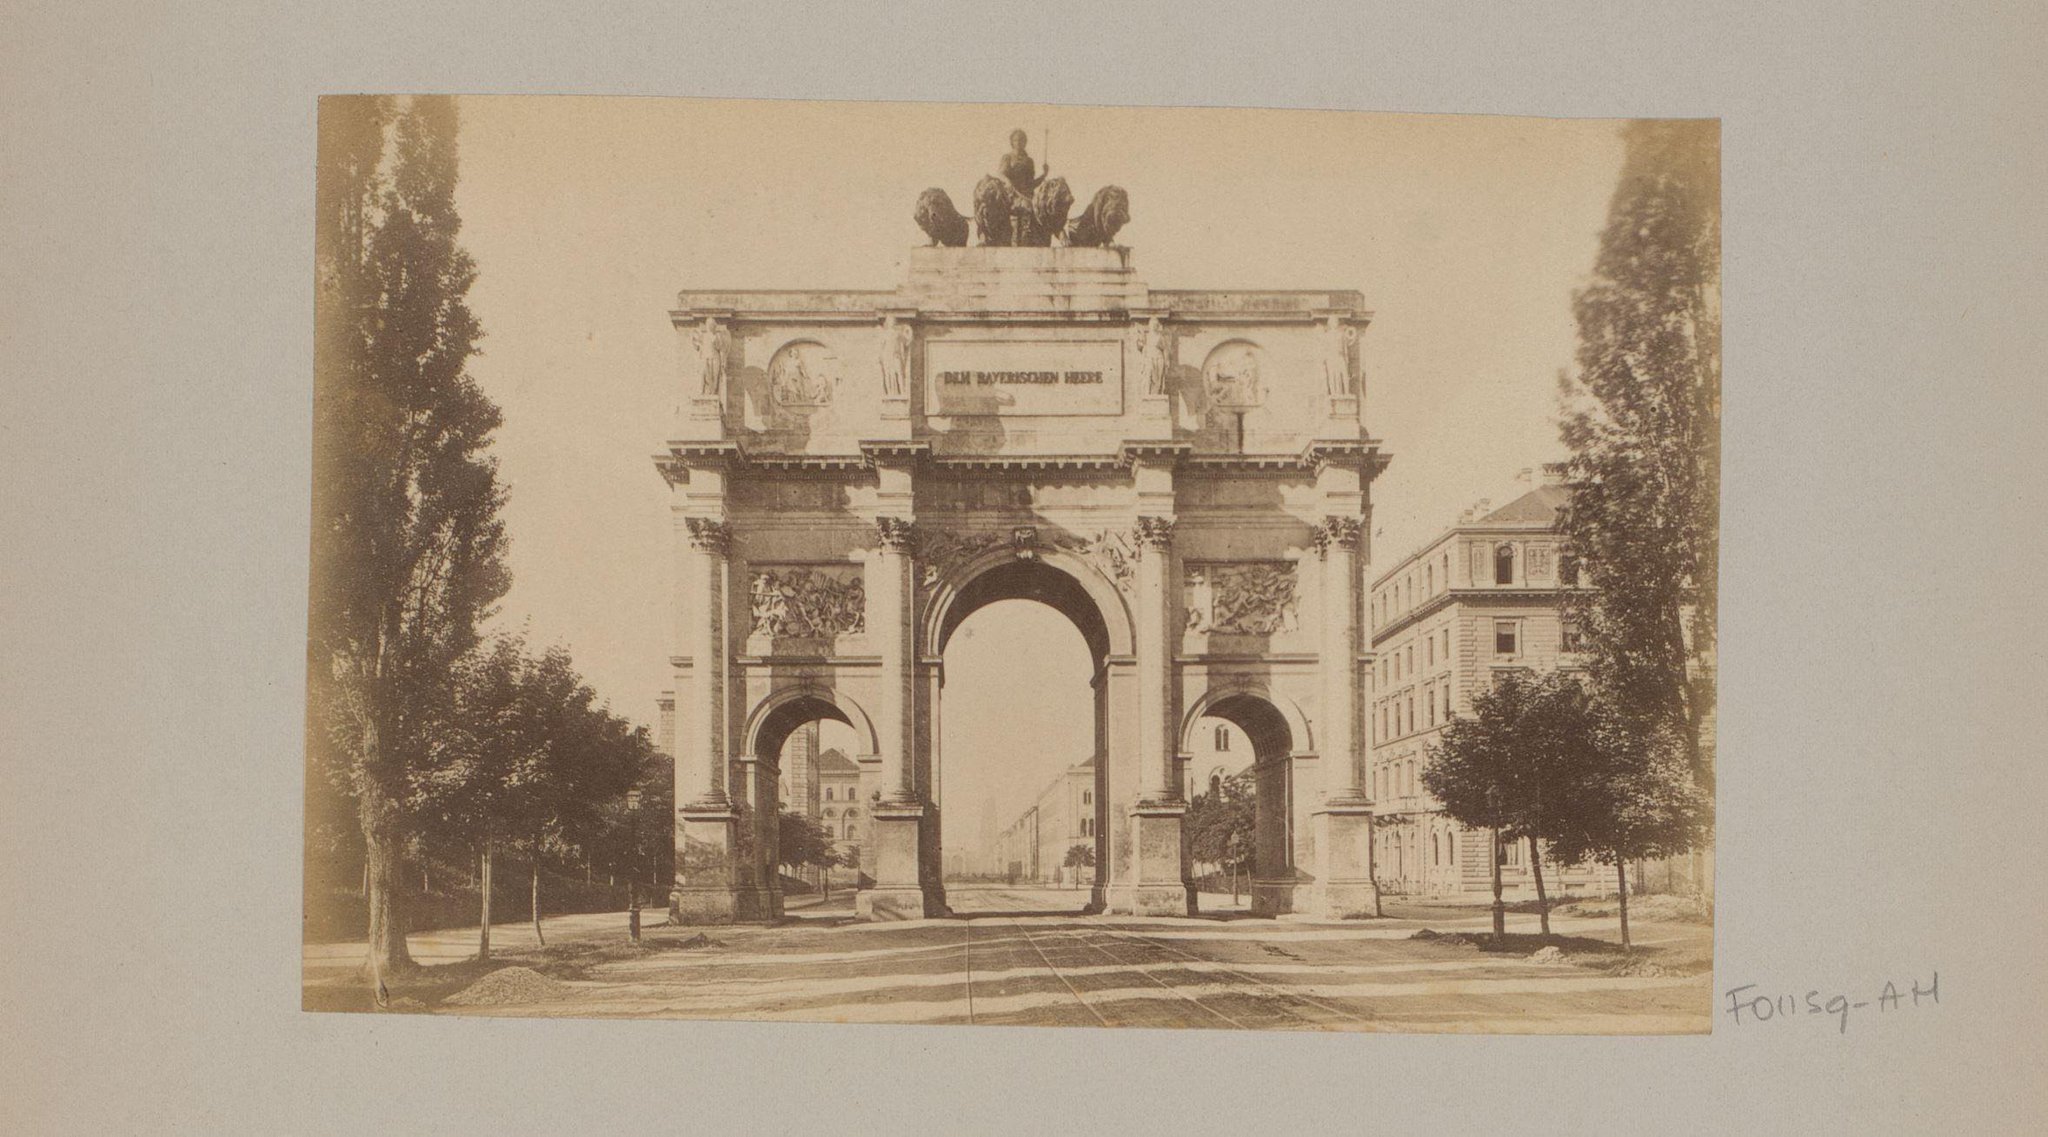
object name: photograph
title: Gezicht op de Siegestor in München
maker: Anonymous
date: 1880-1900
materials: photographic support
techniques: albumen print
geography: munich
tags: triumphal arch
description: Onderdeel van Reisalbum met opnames van bezienswaardigheden in Zweden, Noorwegen, Denemarken, Beieren, Milaan en Parijs.